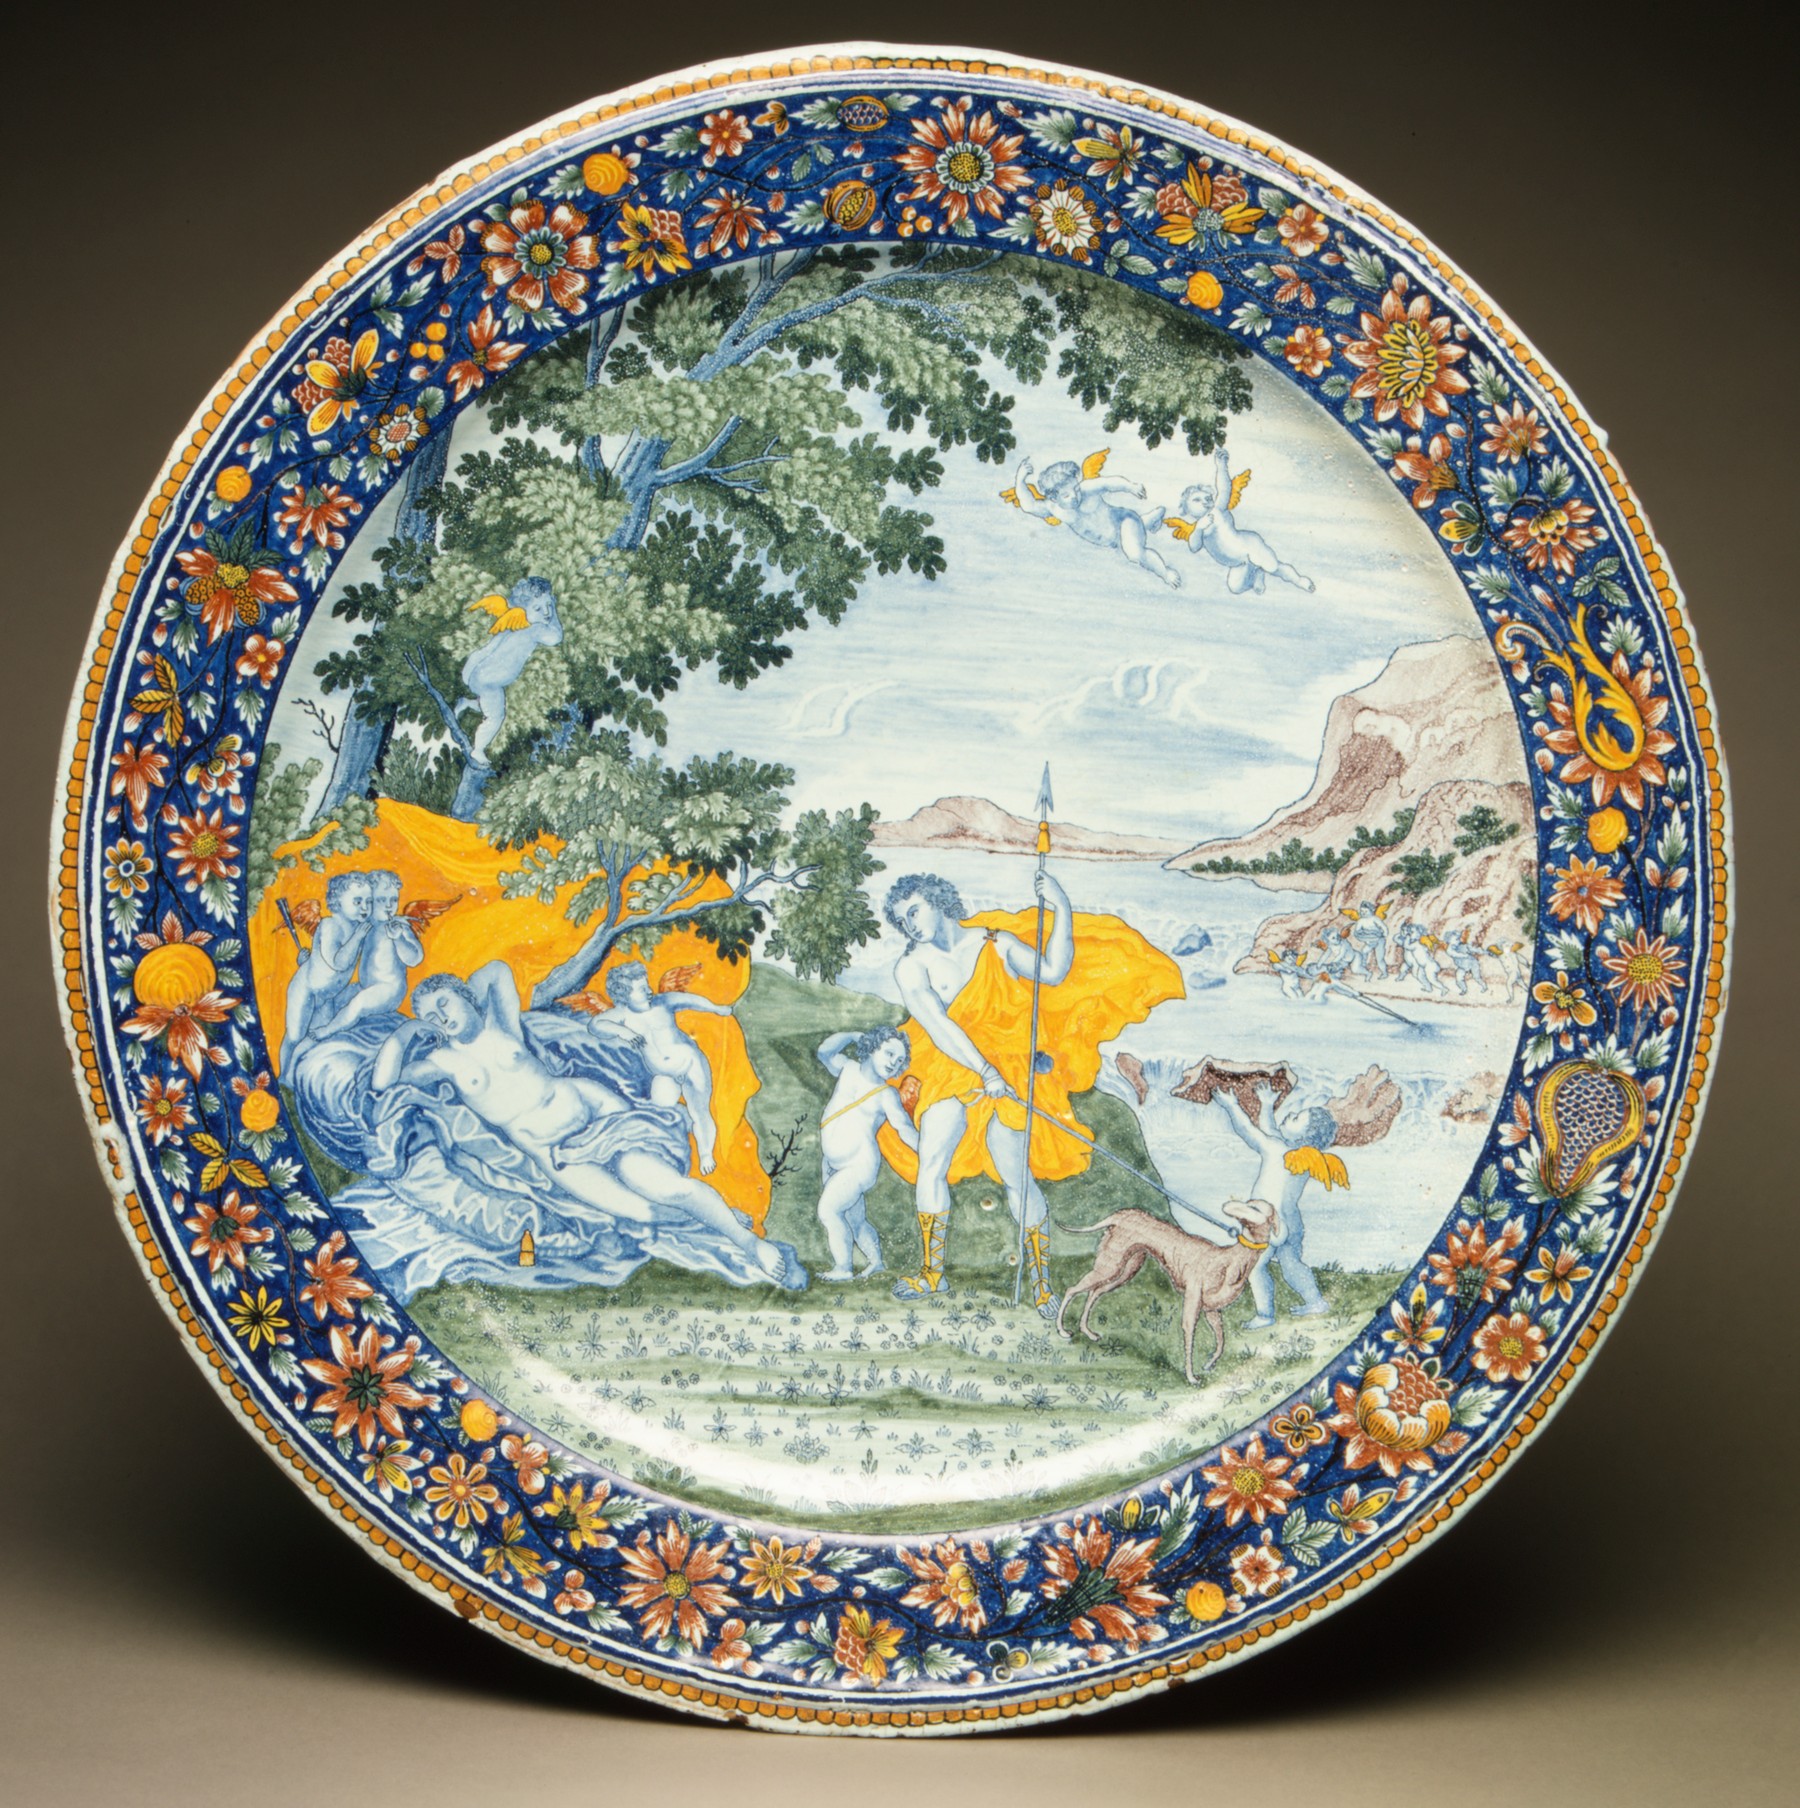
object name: plateau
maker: claude borne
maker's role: artist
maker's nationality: french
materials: faience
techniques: glazing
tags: animals,men,female nudes,trees